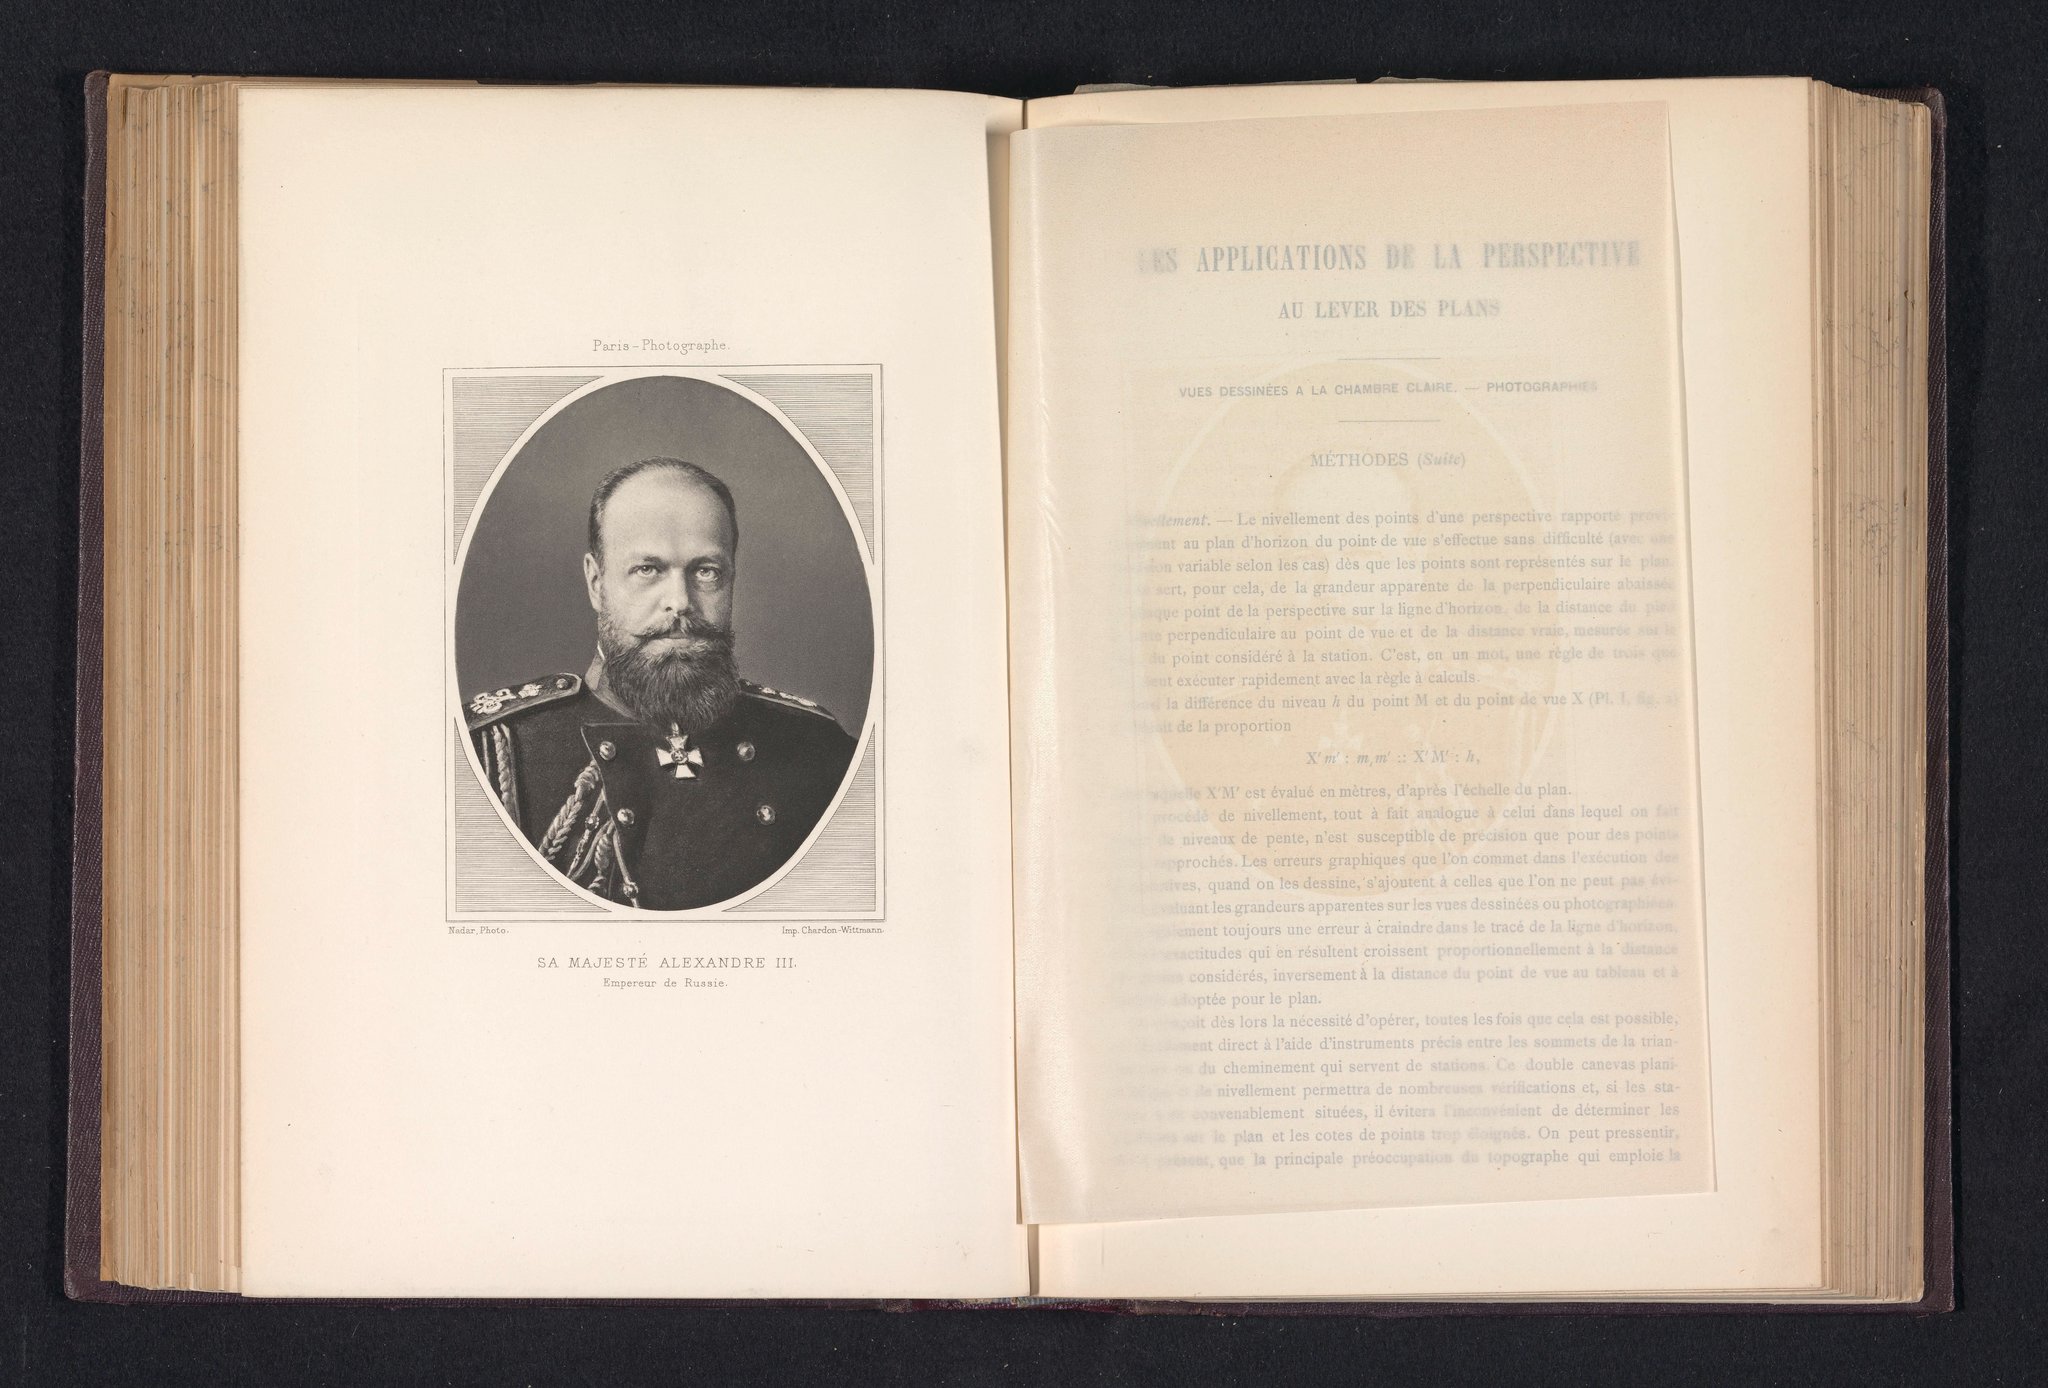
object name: photomechanical print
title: Sa Majesté Alexandre III Empereur de Russie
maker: félix nadar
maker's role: ballonvaarder, fotograaf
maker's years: 1820-1910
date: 1881-1891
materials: paper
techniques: photoaquatint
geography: paris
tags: ruler, sovereign